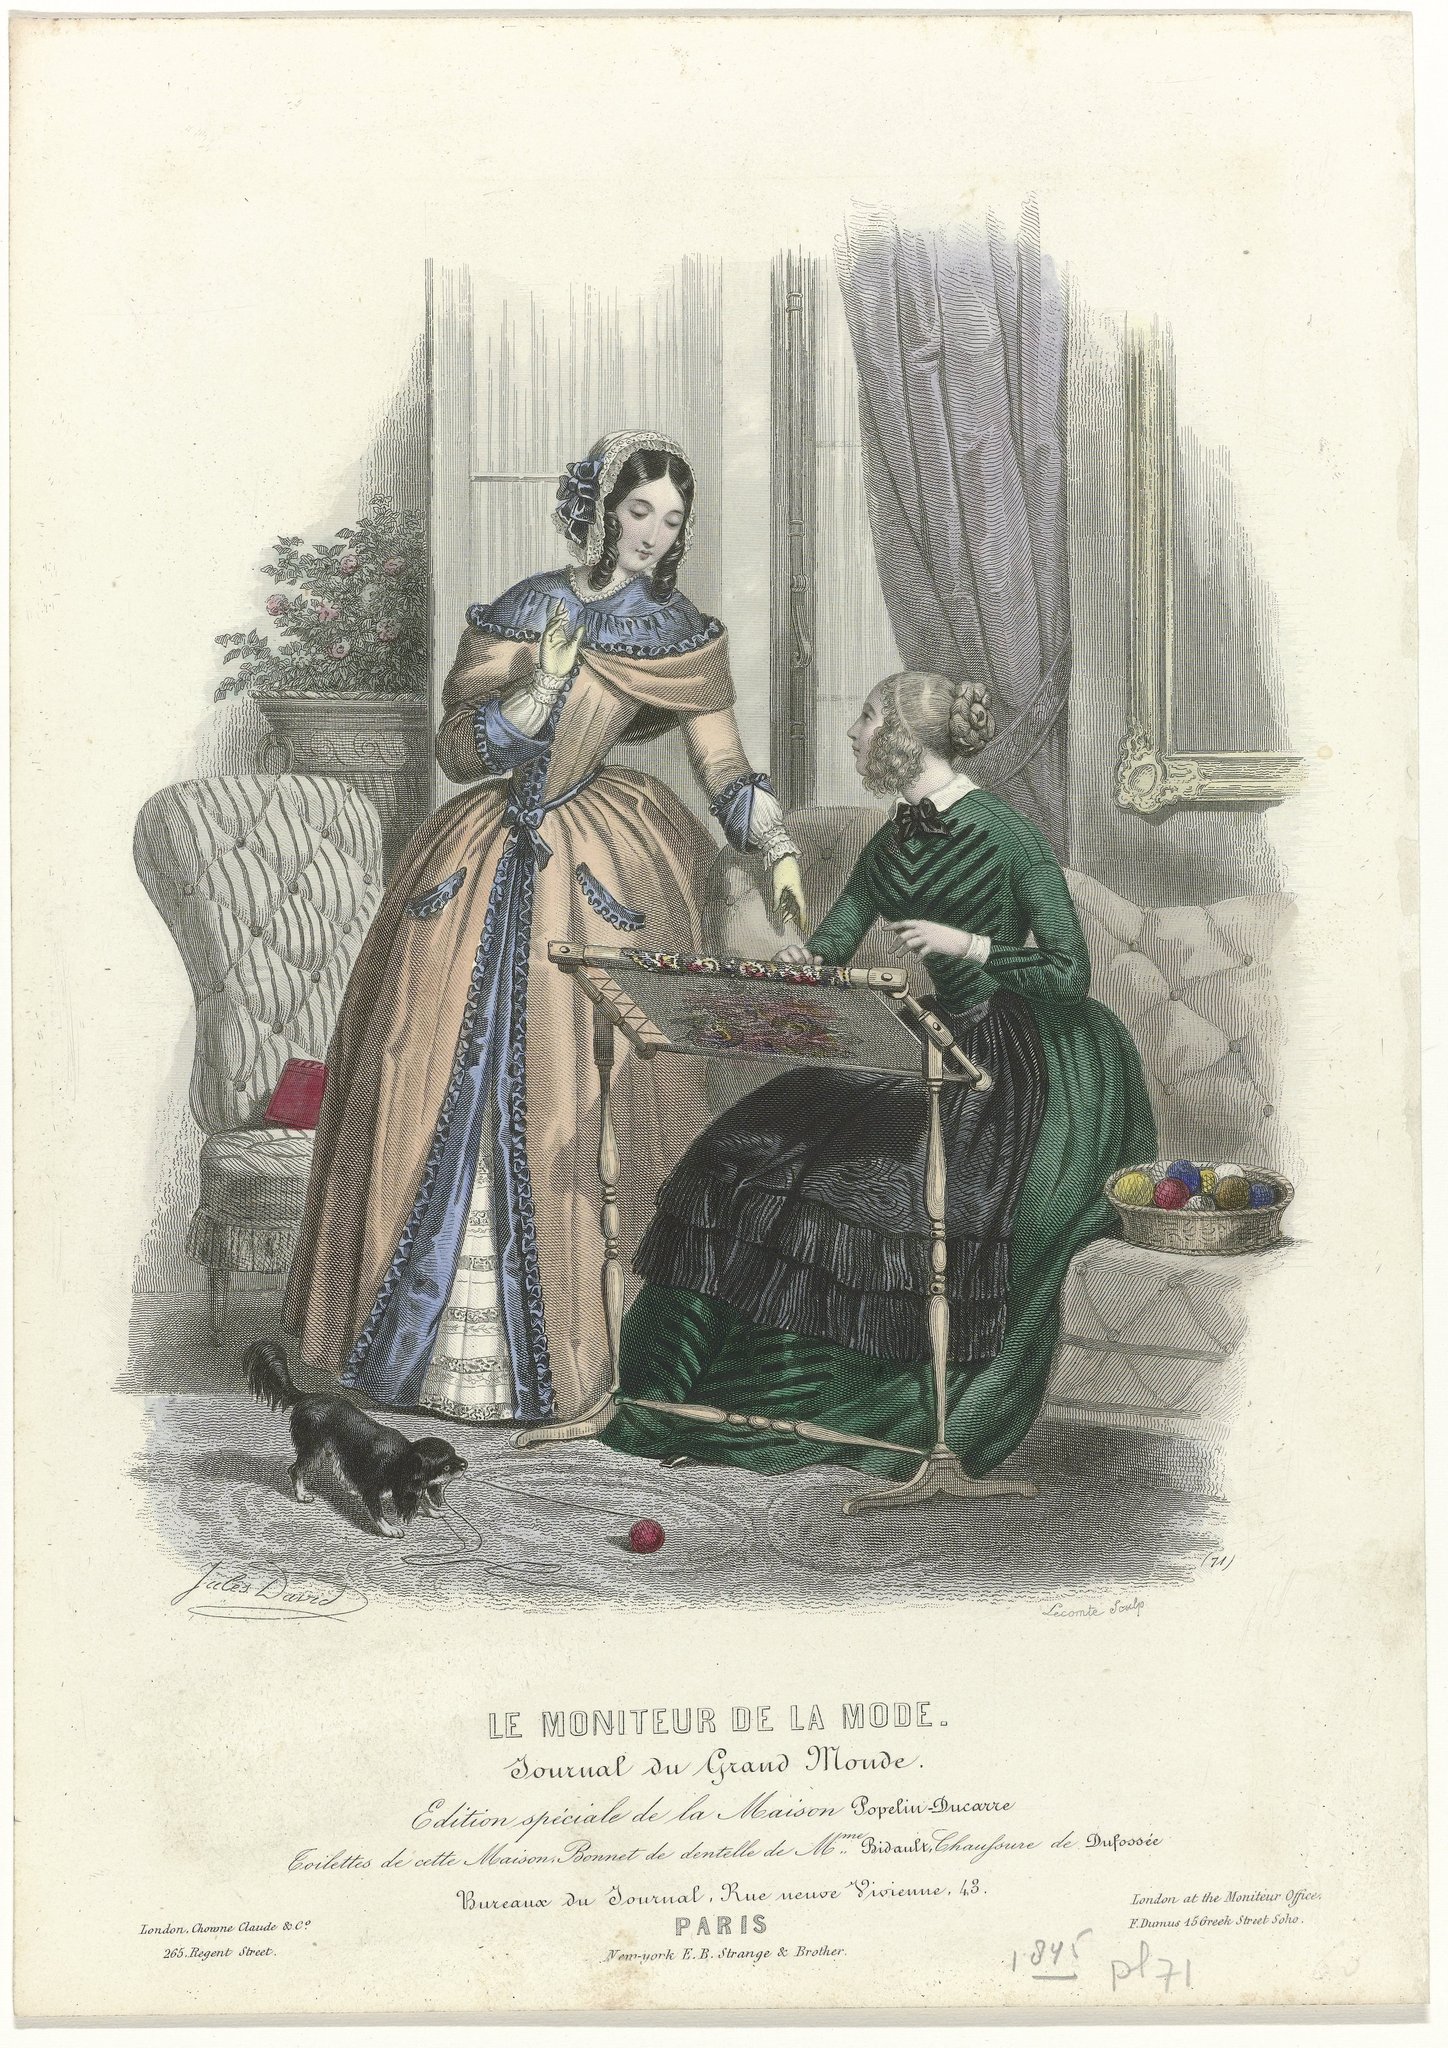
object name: fashion print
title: Le Moniteur de la Mode, 1845, No. 71 : Edition spéciale de la Maison (...)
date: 1845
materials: paper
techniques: engraving, hand coloring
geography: new york city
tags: head-gear: cap (+ women's clothes), fashion plates, shoes, sandals (+ women's clothes), skirt (+ women's clothes), gloves, mittens, etc. (+ women's clothes), dress, gown (+ women's clothes), (other forms of) needlework, e.g.: crocheting, knitting, embroidering, apron (+ women's clothes), neck-gear ~ clothing (+ women's clothes), wool (material ~ textile industry), dog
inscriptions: address: ‘London. Chowne claude & Co 265 Regent Street / Bureaus du Journal, Rue neuve Vivienne, 43. Paris / New York E.B. Strange & Brother. / London at the Moniteur Office. F. Dumus 15 Greek Street Soho.’, caption: ‘Edition spéciale de la Maison Popelin-Ducarre. Toilettes de cette Maison, Bonnet de dentelle de M"me Bidault, Chaussure de Dufossée.’, title: ‘Le Moniteur de la Mode. / Journal du Grand Monde.’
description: Twee vrouwen in eejn interieur, van wie één aan het borduren is achter een borduurraam. Op de bank ligt een mandje met bollen wol. Op de voorgrond speelt een hondje met een bol wol. Volgens het onderschrift: 'toilettes' van Maison Popelin-Ducarre. Muts van kant van Bidault. Schoenen van Dufossée. Prent uit het modetijdschrift Le Moniteur de la Mode (1843-1913).